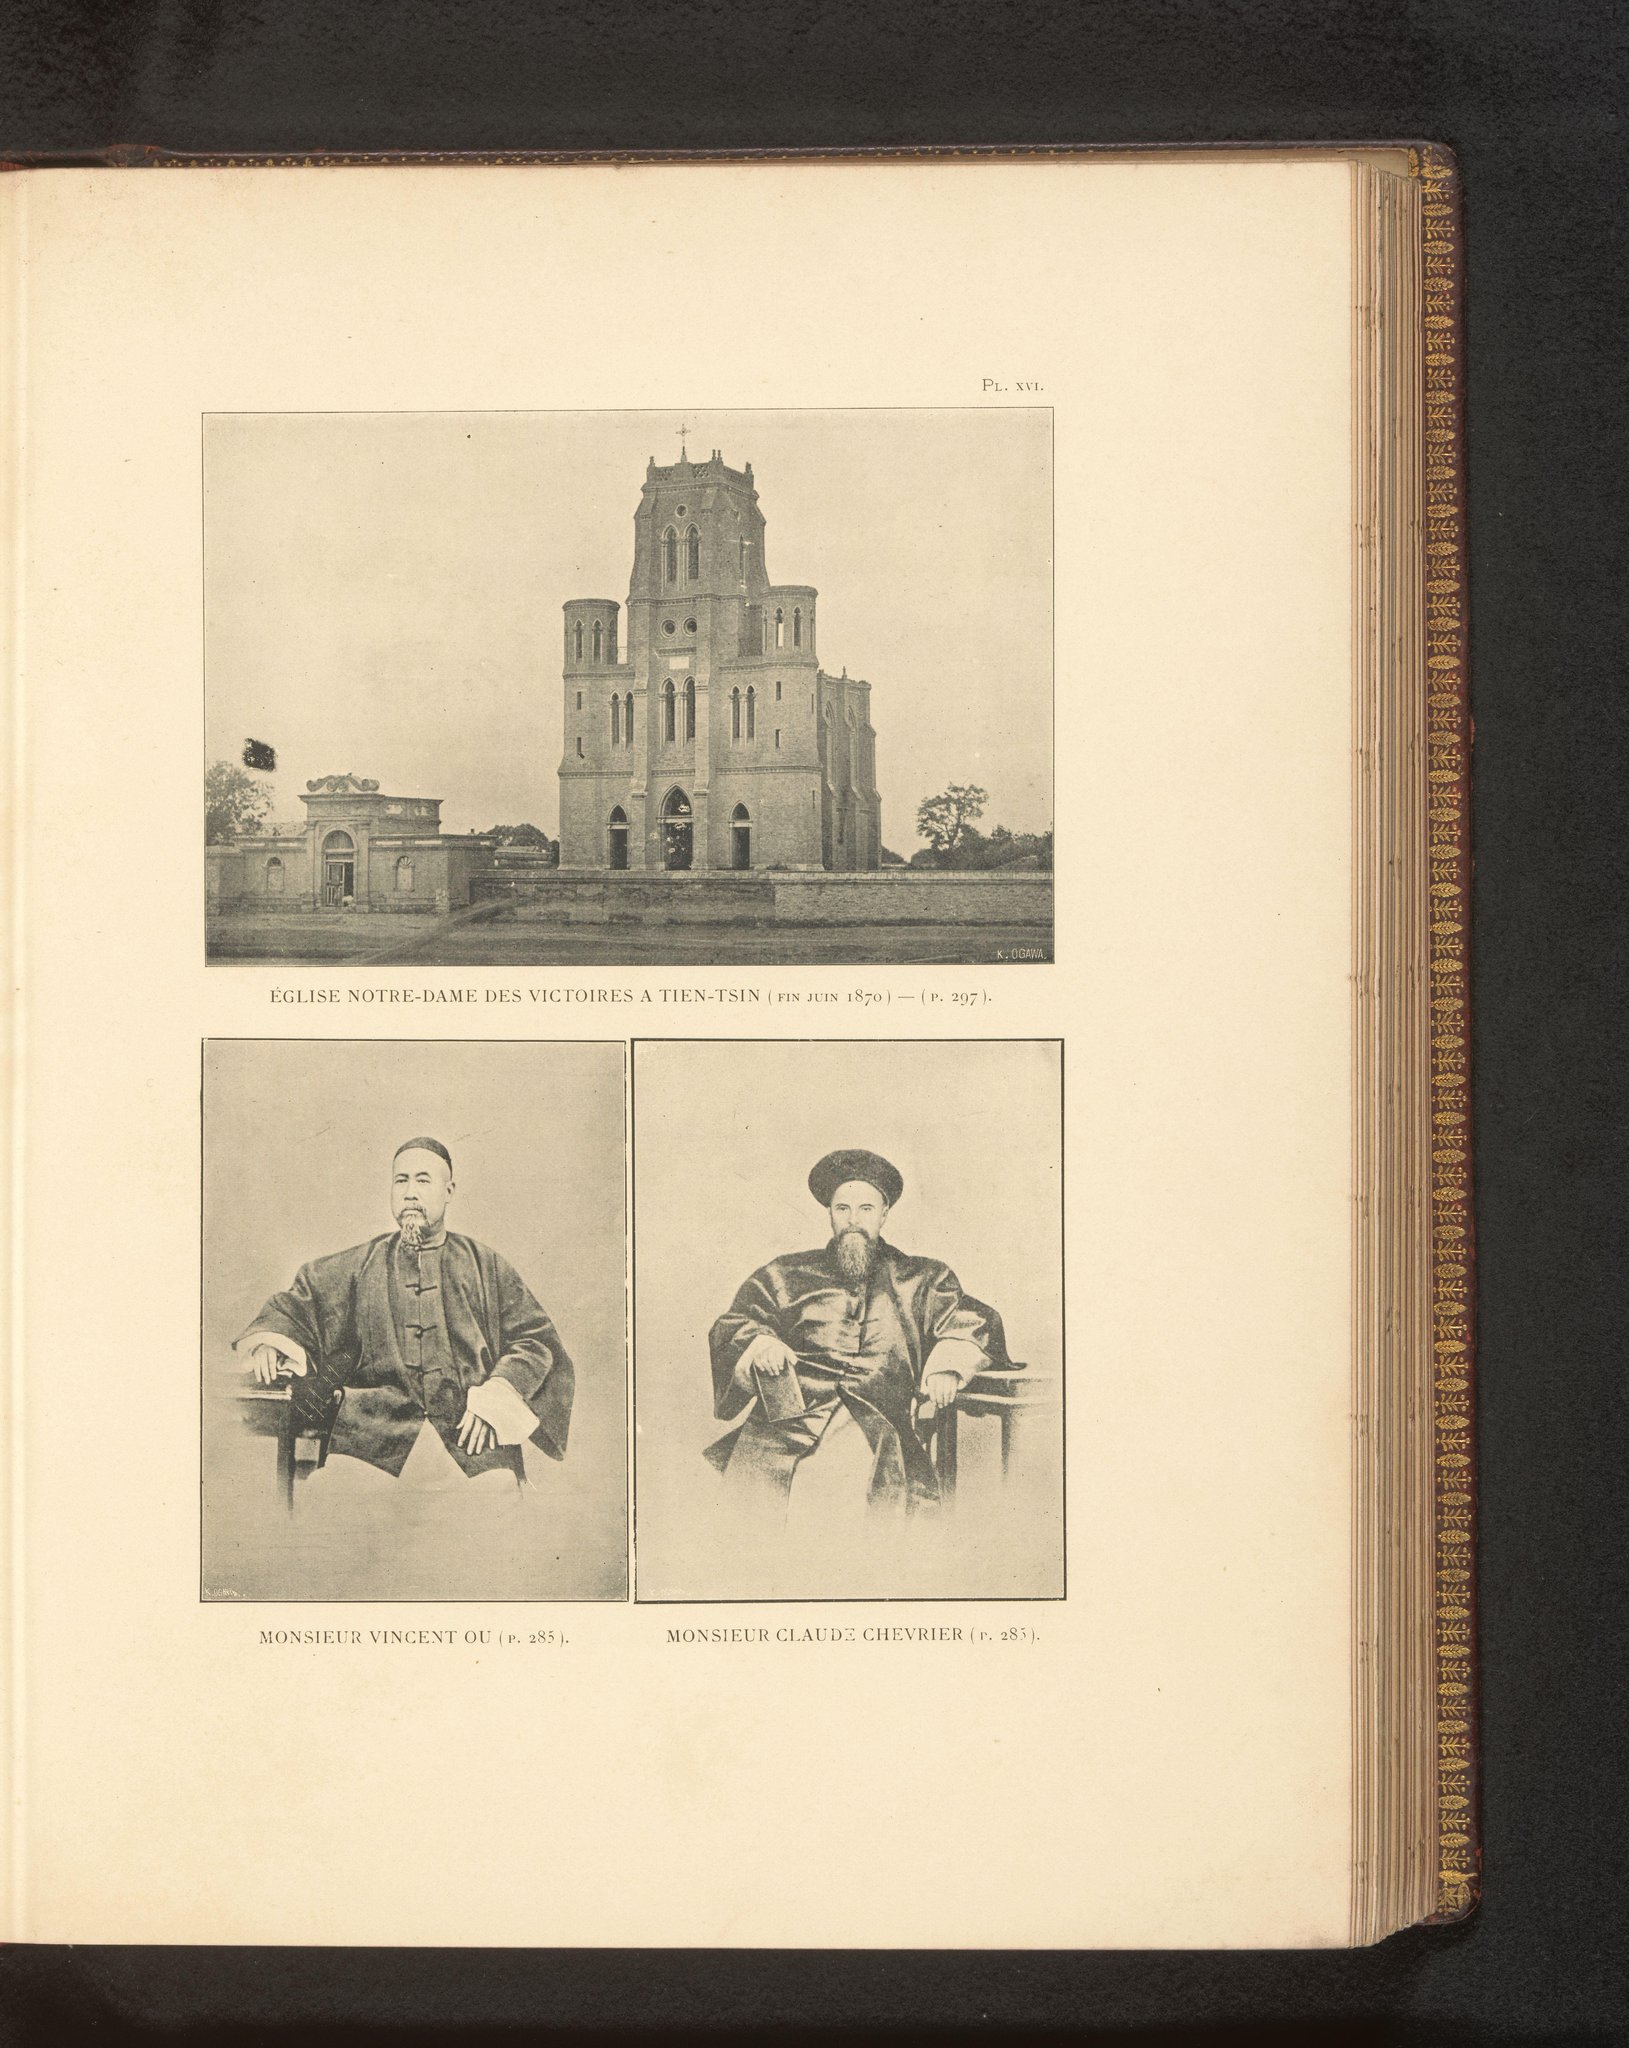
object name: photomechanical print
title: Gezicht op de Wanghailou-kerk te Tianjin, Portret van Vincent Ou en Portret van Claude Chevier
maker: Anonymous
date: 1892-1897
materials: paper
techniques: autotype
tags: adult man, historical persons, church (exterior)